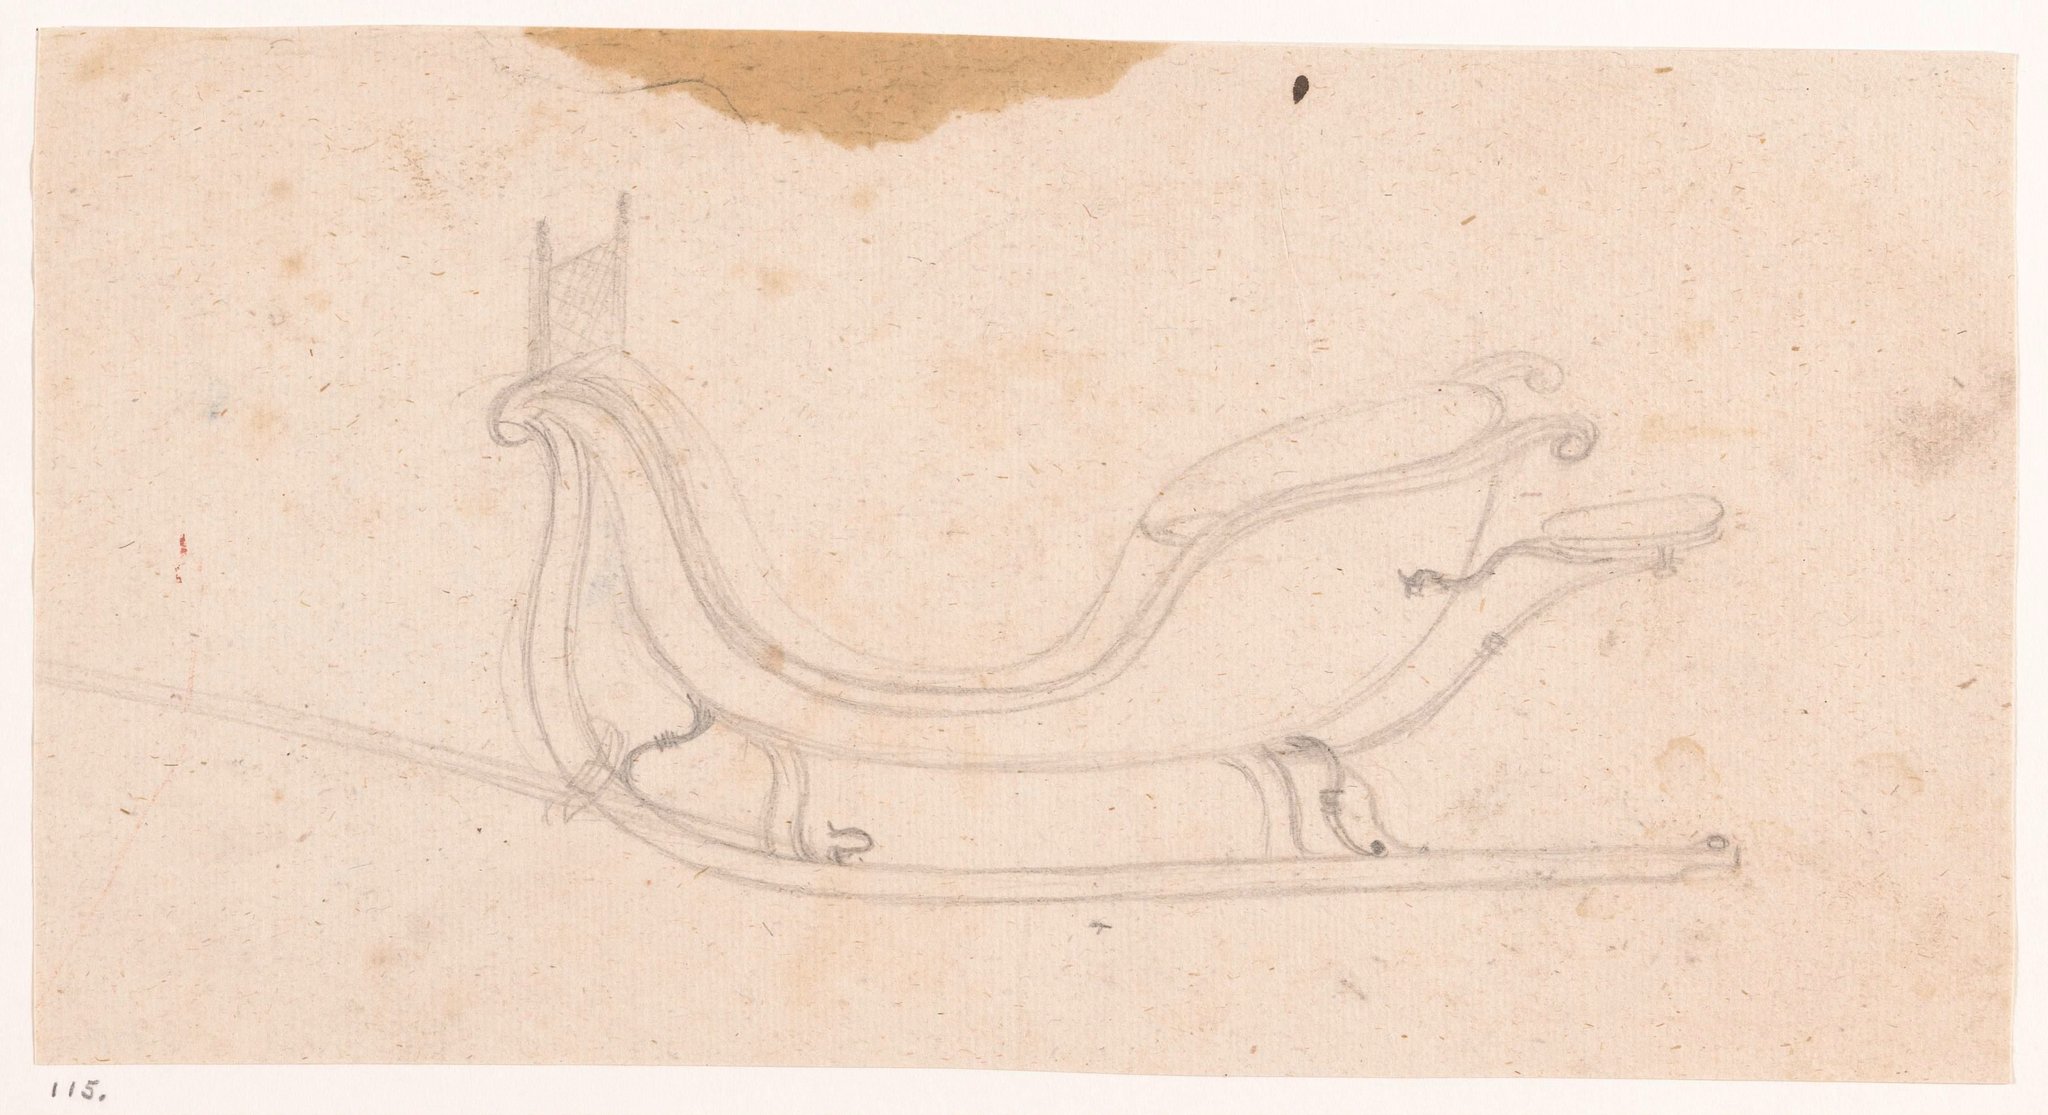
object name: drawing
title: Arrenslee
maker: jan brandes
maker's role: draughtsman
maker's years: 1743-1808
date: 1787-1808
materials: paper, pencil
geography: skälsebo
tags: sleigh, sledge (non-sport)